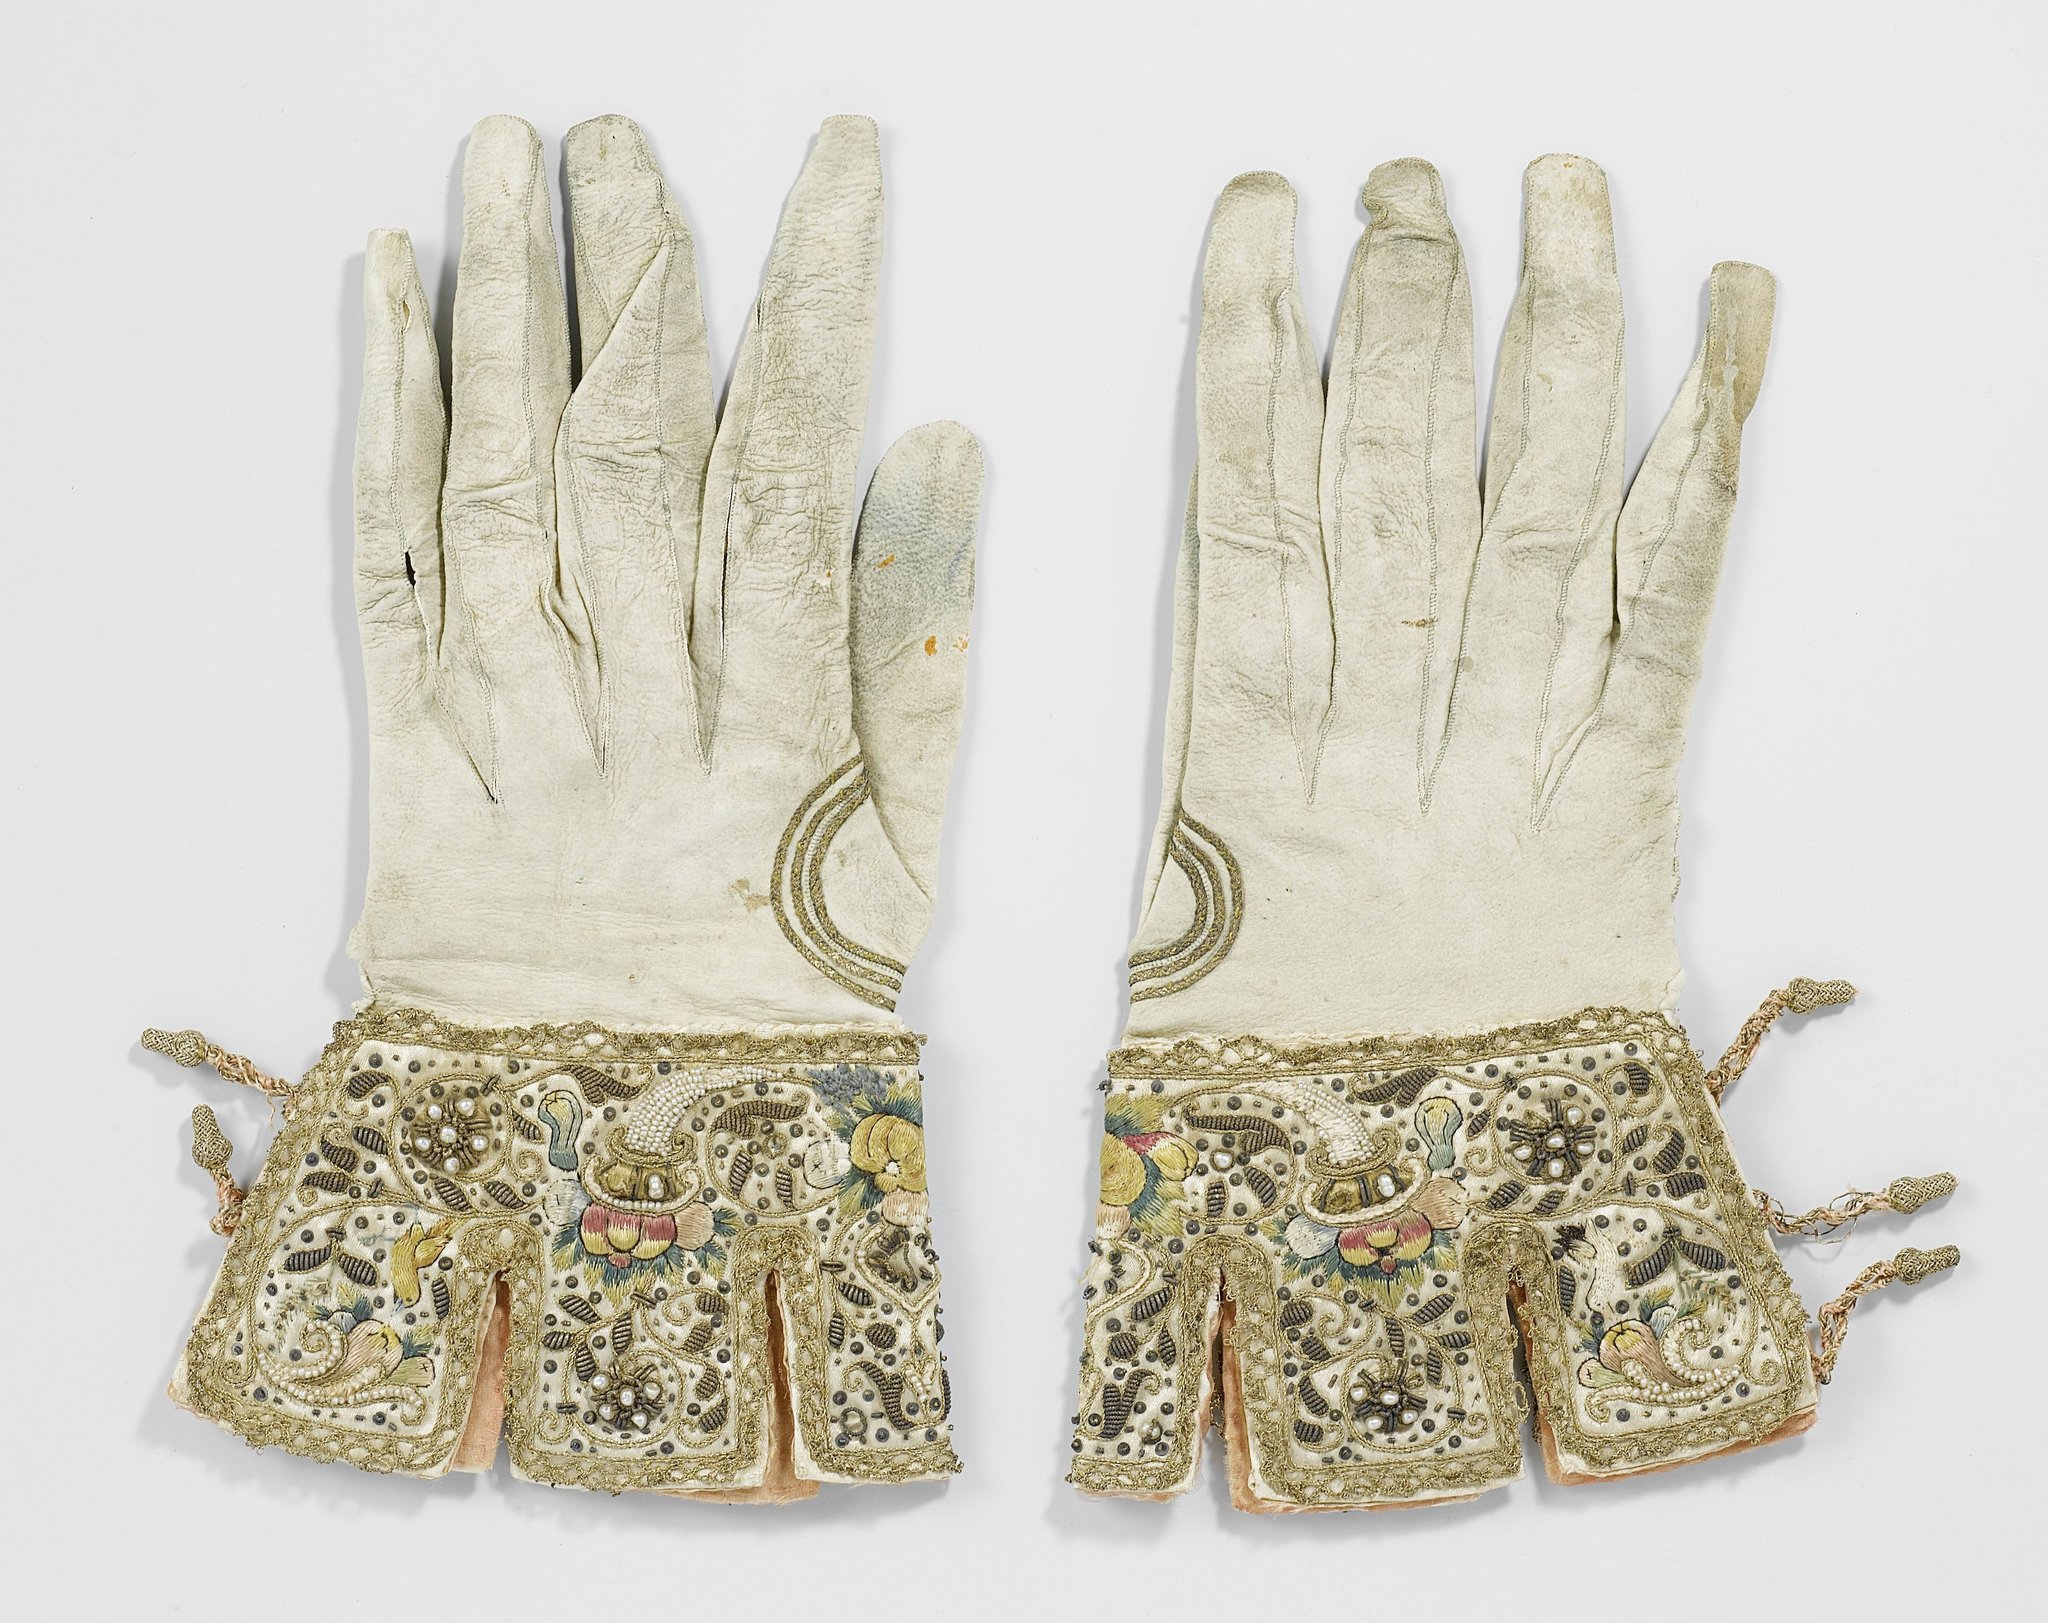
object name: glove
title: Handschoen van wit leer met ingesneden crèmekleurige zijden kap, waarop borduurwerk van gouddraad met zoetwaterpareltjes, veelkeurige zijde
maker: Anonymous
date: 1600-1625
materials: leather, gold thread, pearl, silk, silver, thread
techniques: embroidered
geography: northern netherlands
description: Handschoenen van wit leer met ingesneden crèmekleurige zijden kap, waarop borduurwerk met vruchten, bloemen, hoorn des overvloeds en vogels van gouddraad met zoetwaterpareltjes, veelkeurige zijde en zilveren lovers, gevoerd met roze zijde. Aan het uiteinde van de kap elk drie eikeltjes van gouddraad met zijden bandjes.